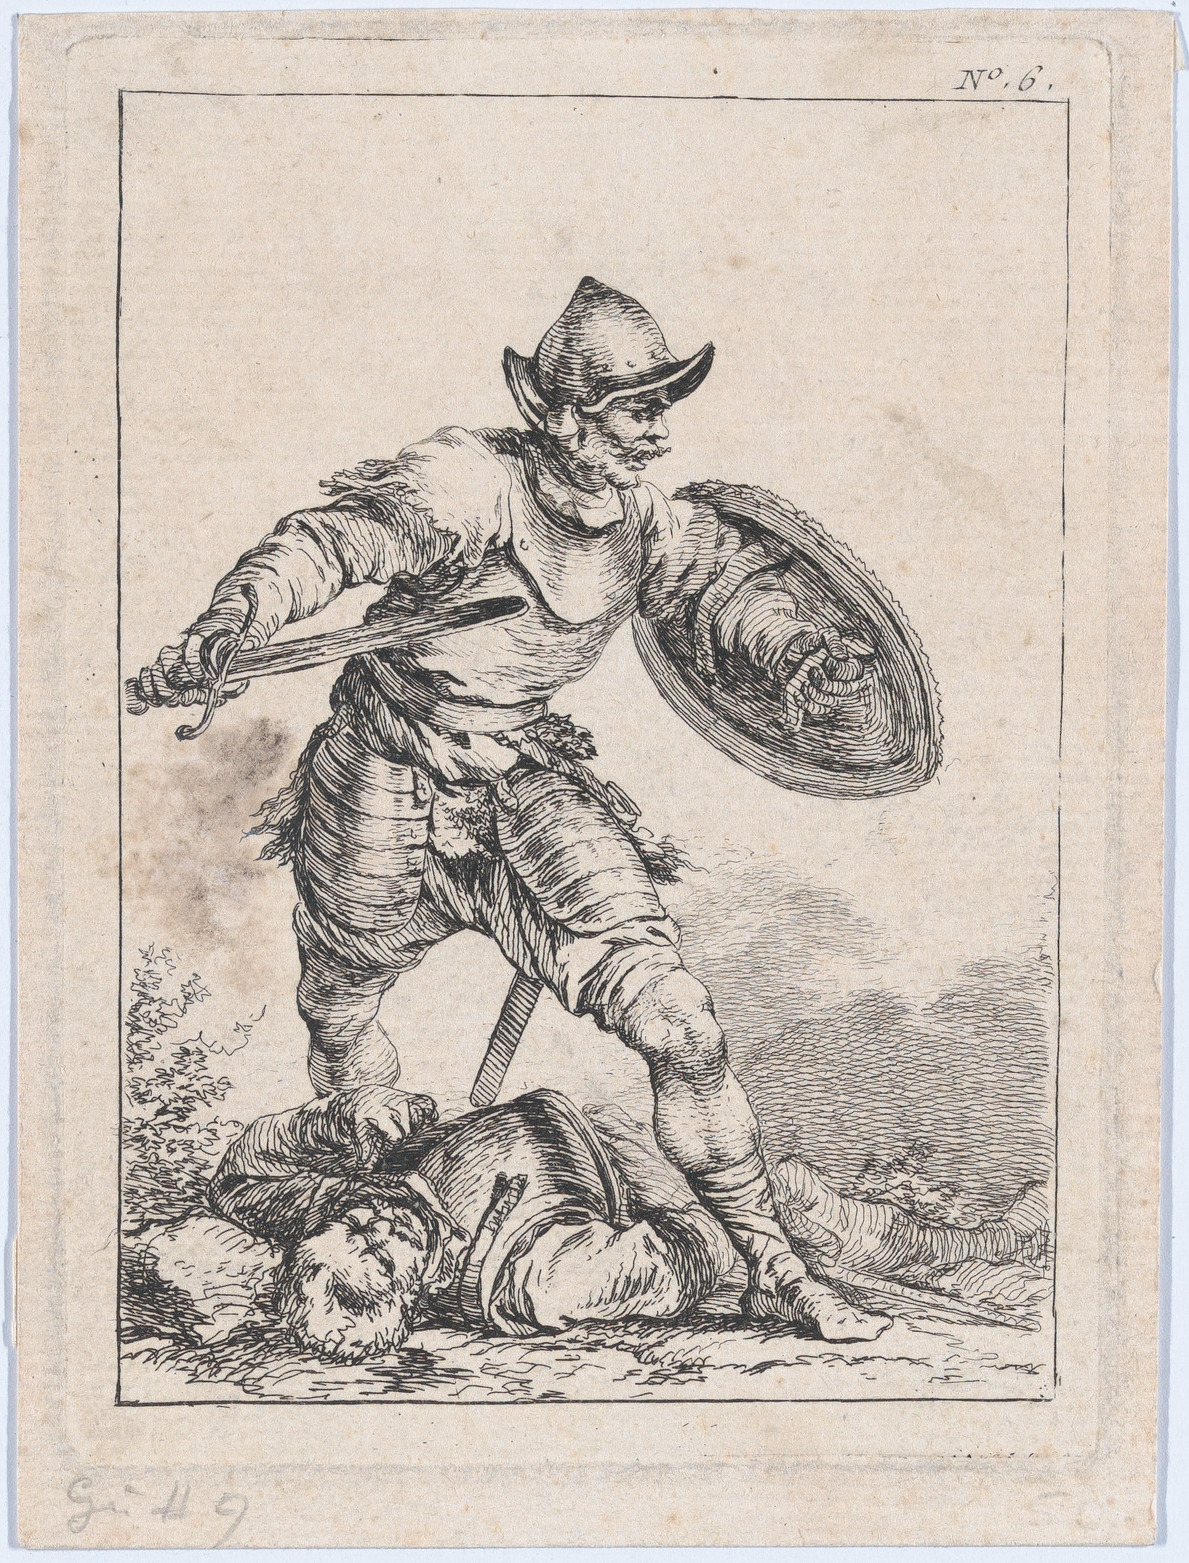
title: Soldier with Sword and Shield, Stepping over a Body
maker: philippe jacques de loutherbourg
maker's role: artist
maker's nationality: french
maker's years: 1740-1812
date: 1755-1771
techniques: etching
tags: soldiers,shields,swords,men